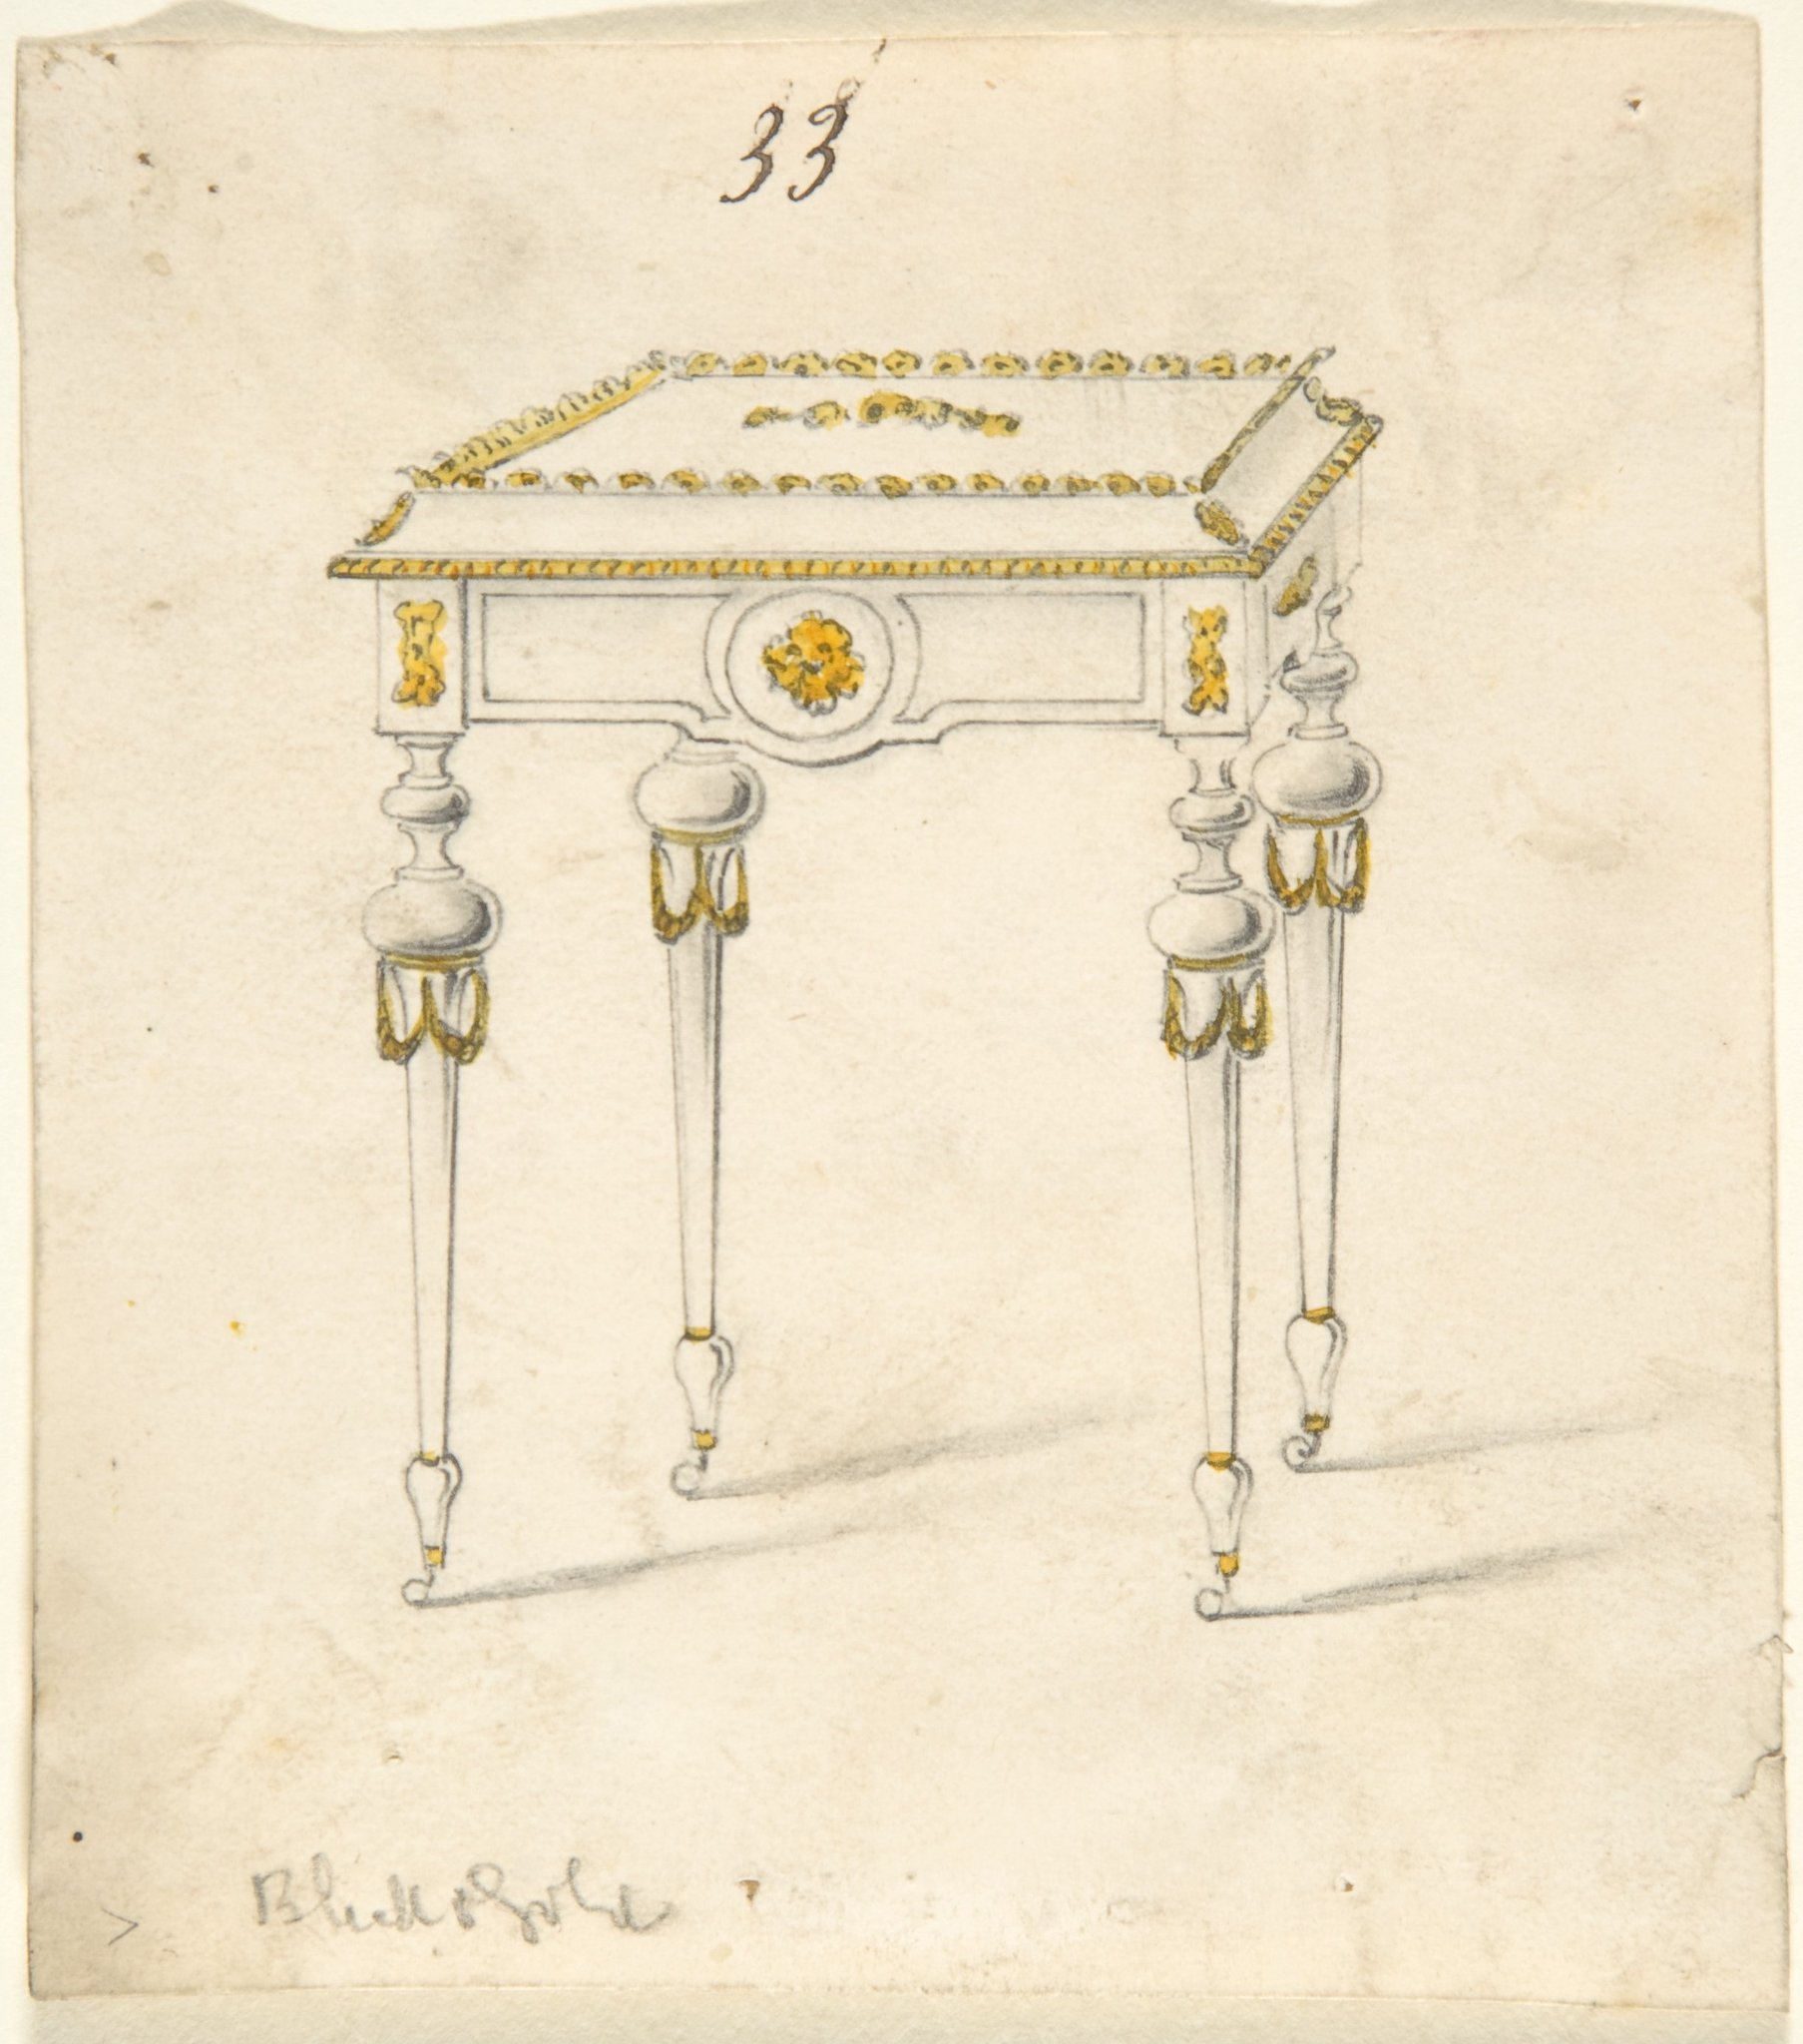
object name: drawing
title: Design for a Small Table on Casters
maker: anonymous, british, 19th century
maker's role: artist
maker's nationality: british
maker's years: 1800-1900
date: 1801-1900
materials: graphite, ink, watercolor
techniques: pen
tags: tables